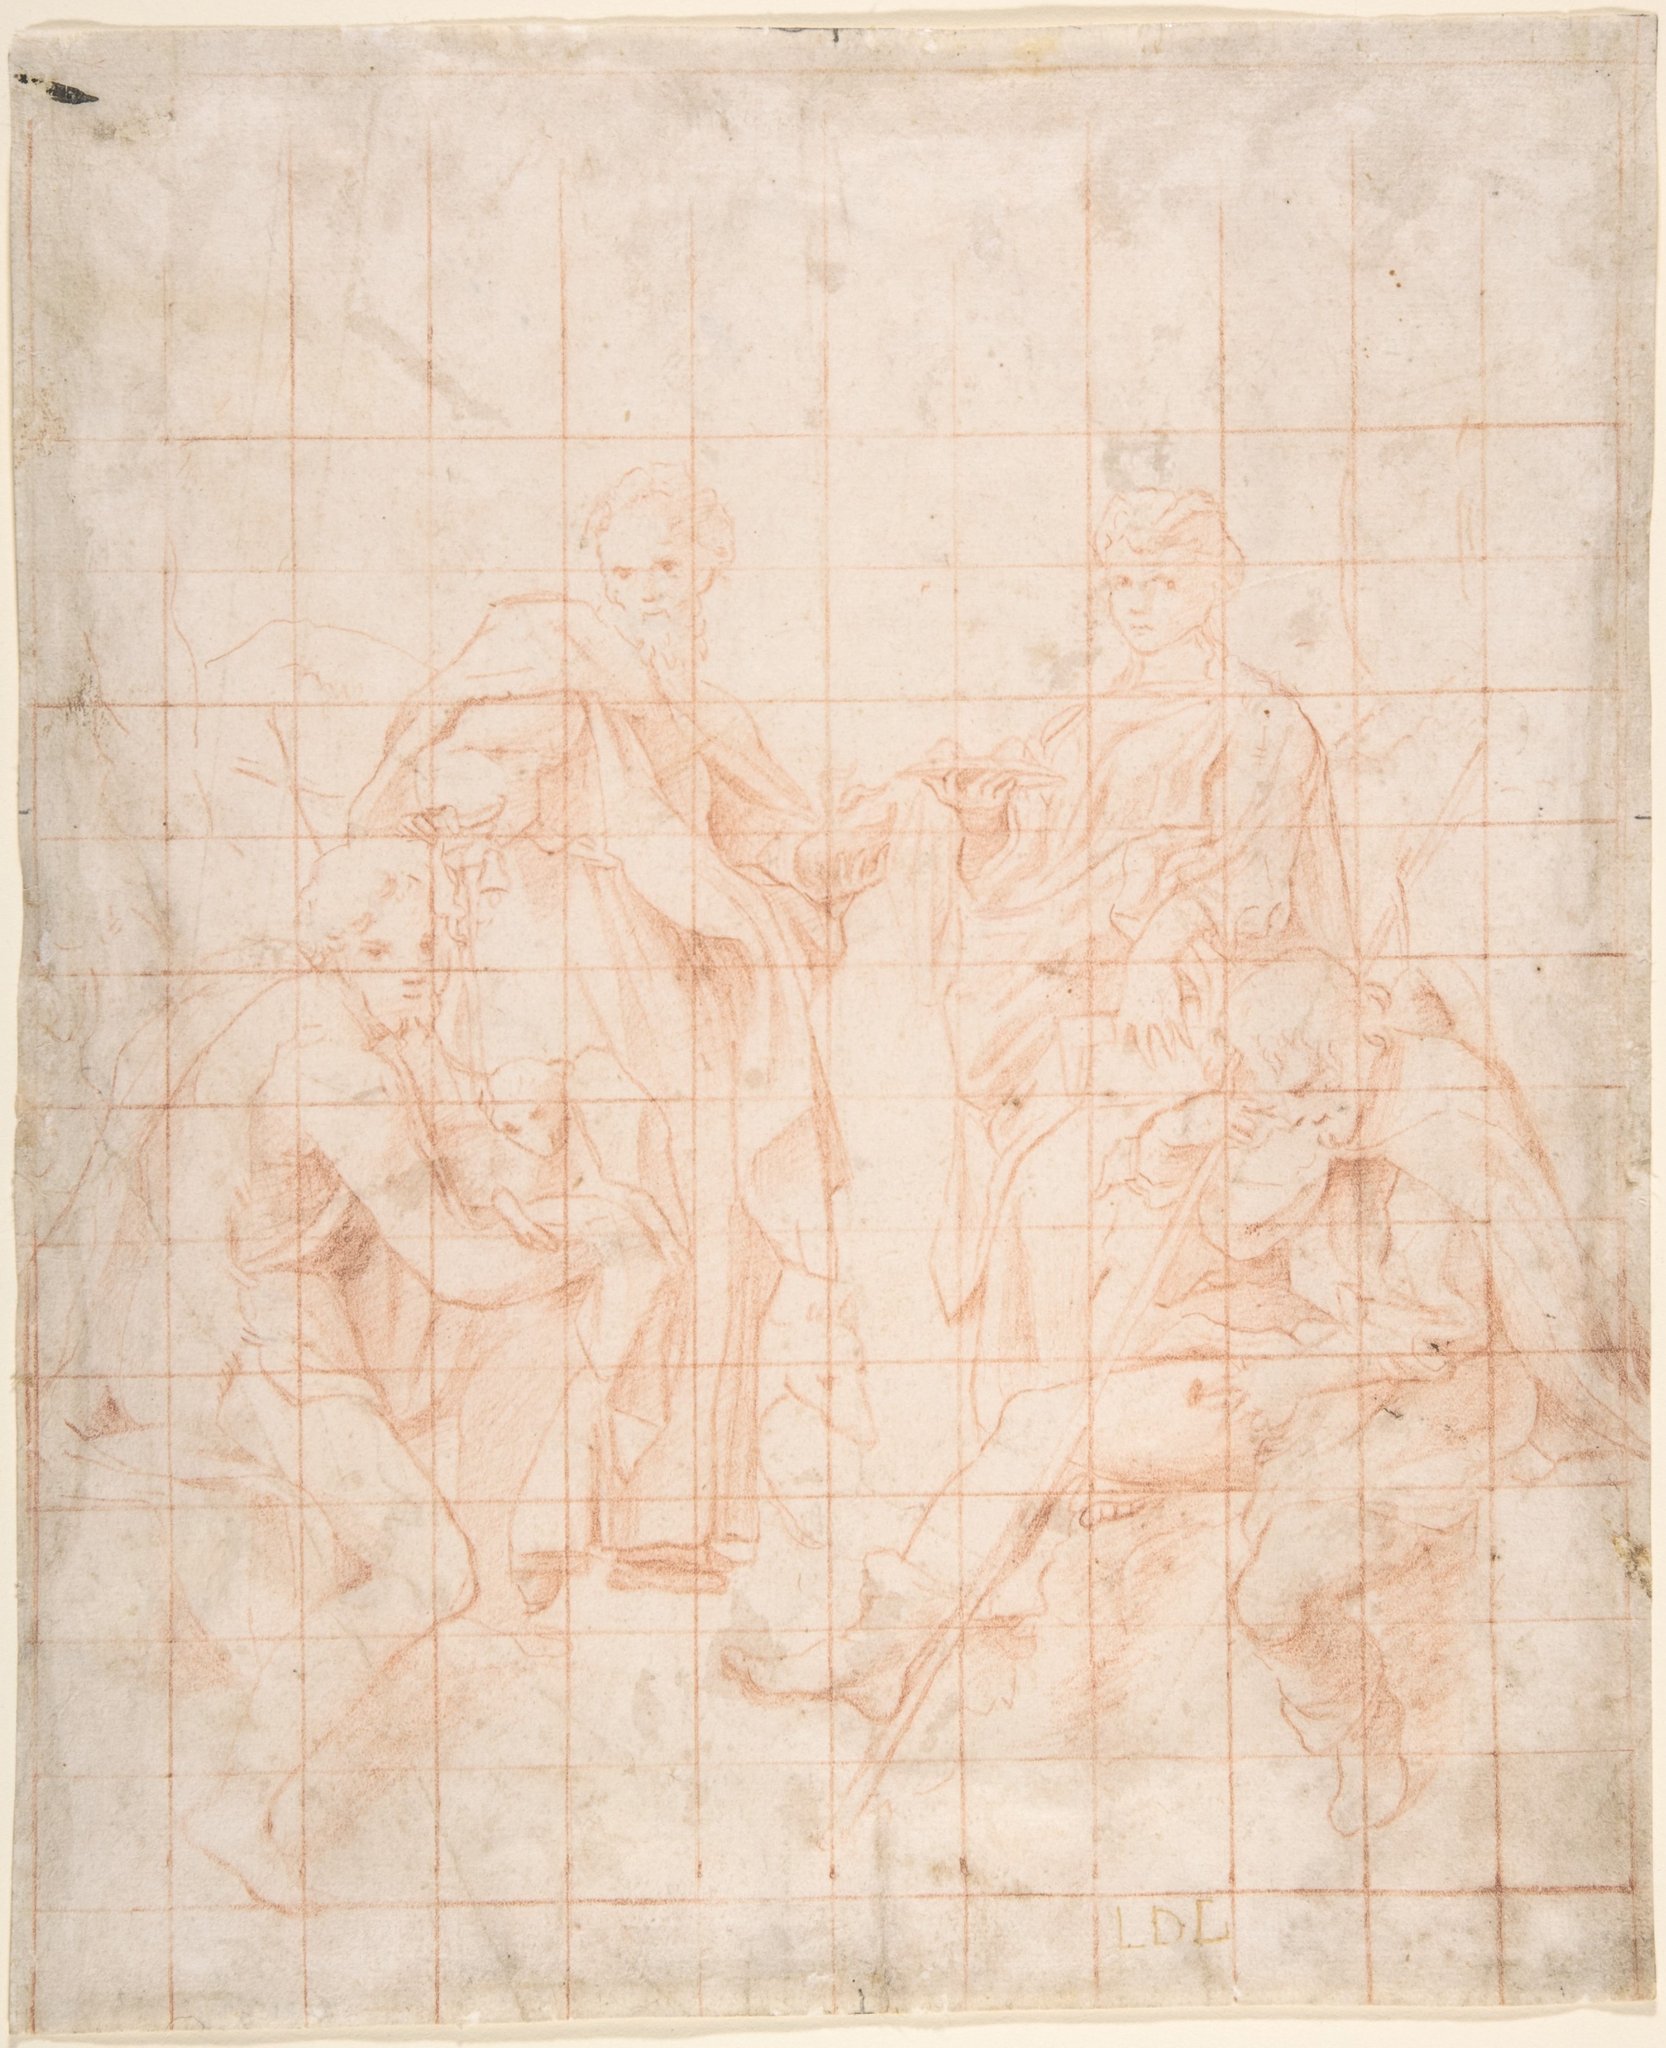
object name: drawing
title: Study of Four Saints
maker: correggio (antonio allegri)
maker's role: artist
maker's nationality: italian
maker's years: 1514-1534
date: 1525-1534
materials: chalk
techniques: drawing, transfer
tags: saints